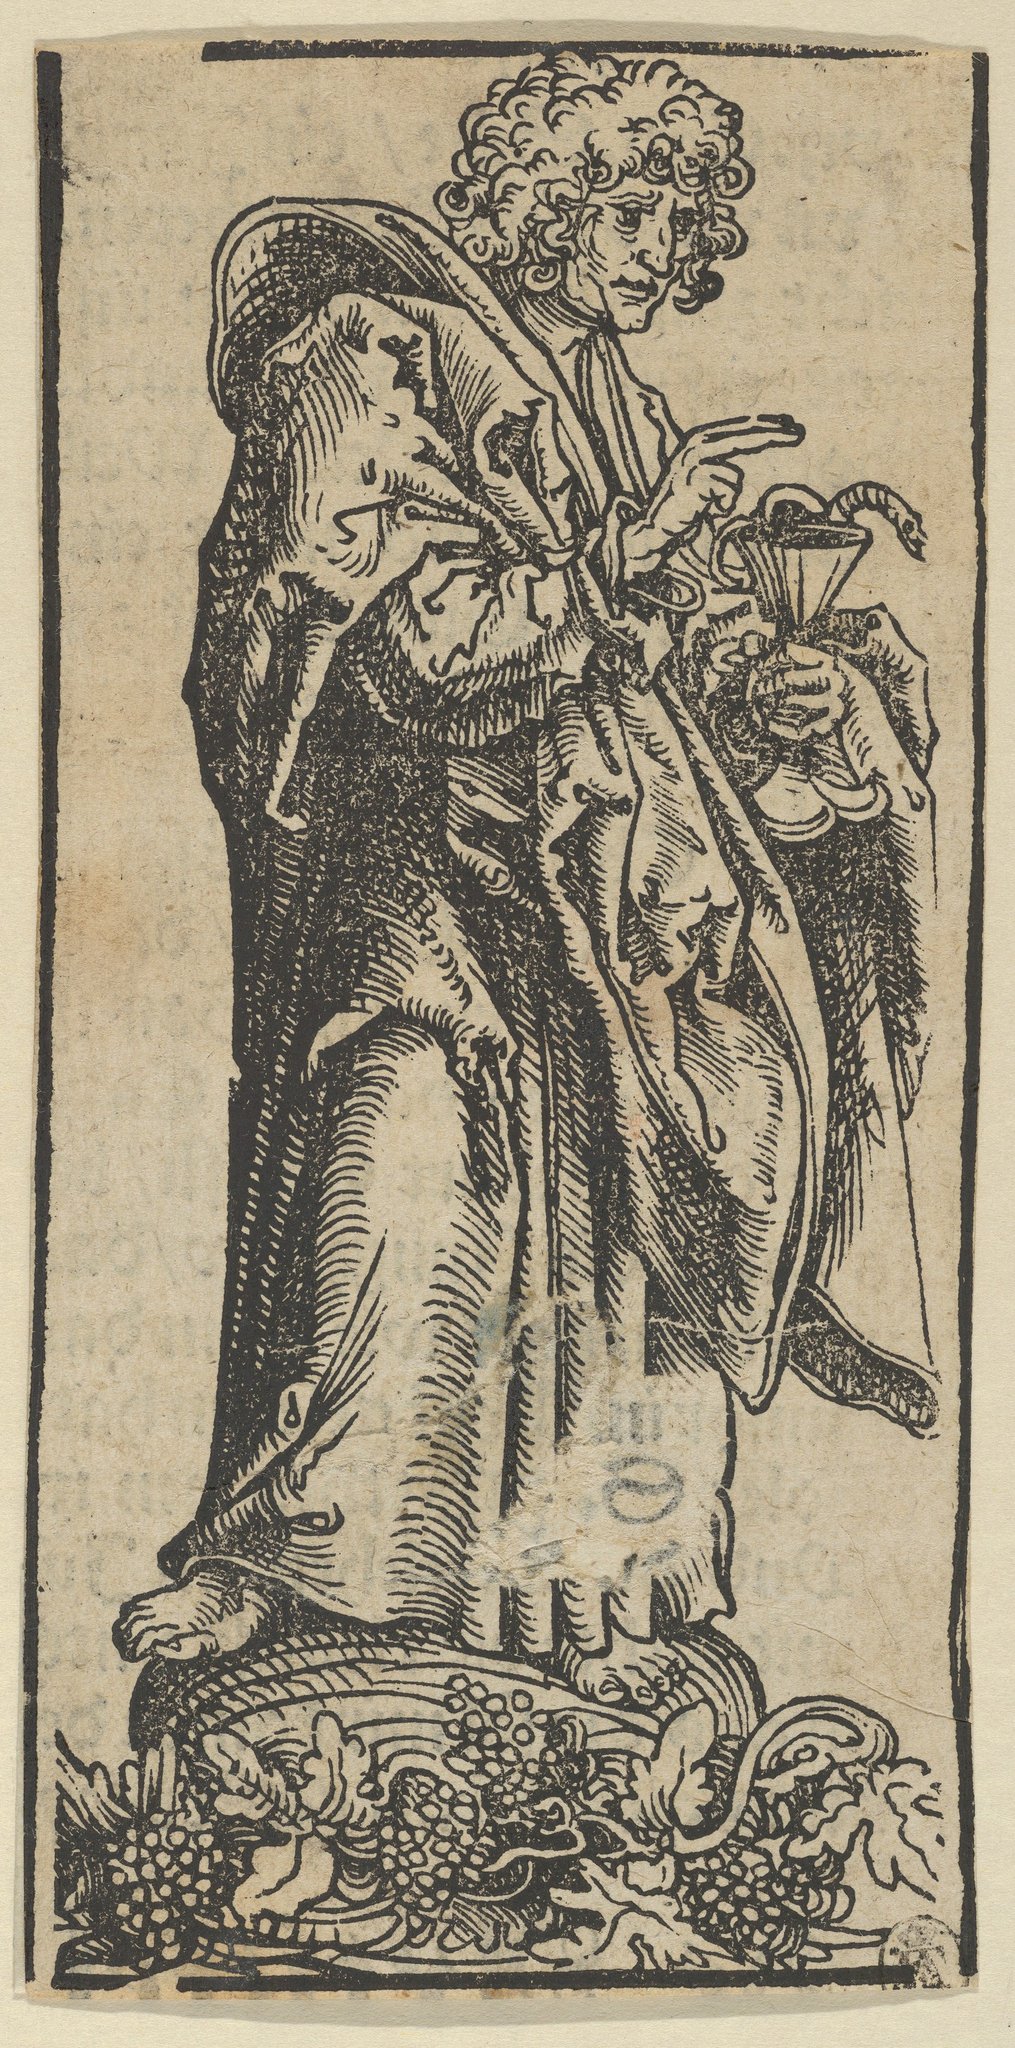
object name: print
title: Silver Statuette of St. John, from the "Wittenberg Reliquaries"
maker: lucas cranach the elder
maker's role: artist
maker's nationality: german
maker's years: 1472-1553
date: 1472-1553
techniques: woodcut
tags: saint john the baptist,reliquaries